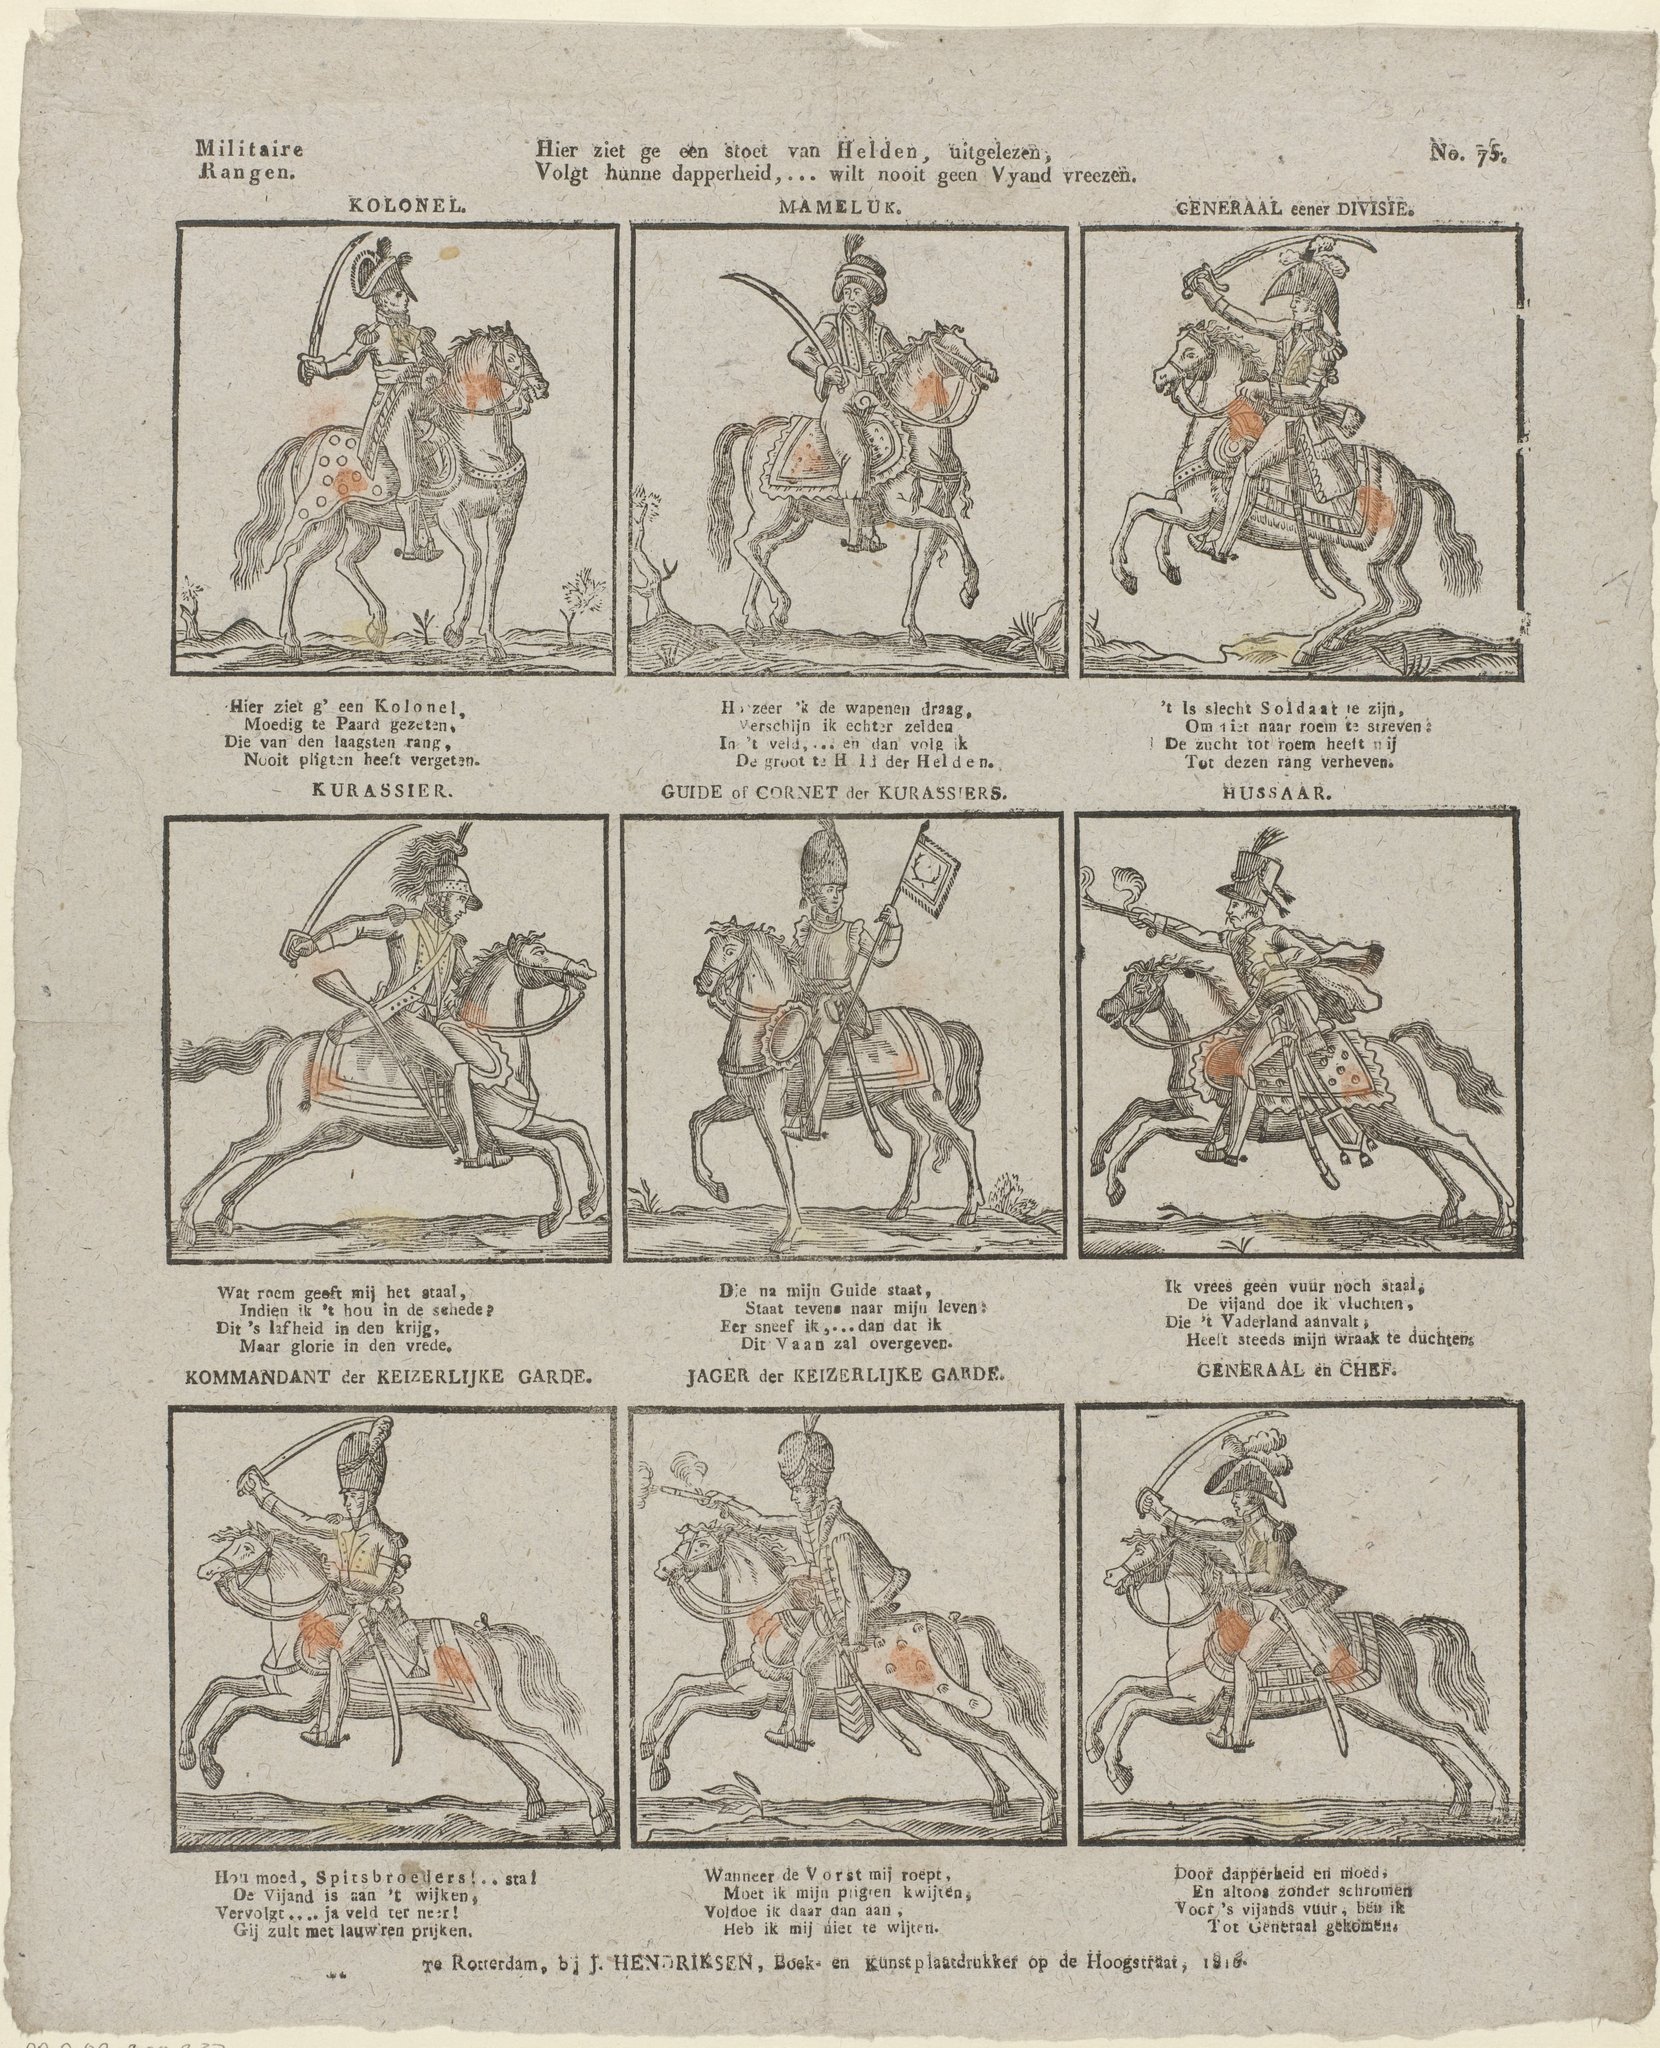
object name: print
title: hier ziet ge een stoet van helden, uitgelezen, / Volgt hunne dapperheid, (...) wilt nooit geen vyand vreezen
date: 1781-1828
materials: paper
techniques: colour, letterpress printing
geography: rotterdam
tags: warfare; military affairs (+ cavalry, horsemen), the soldier; the soldier's life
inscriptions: collector's mark: Lugt 2760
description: Blad met 9 voorstellingen van militairen te paard. Onder elke voorstelling een vierregelig vers. Genummerd rechts boven: No. 75.